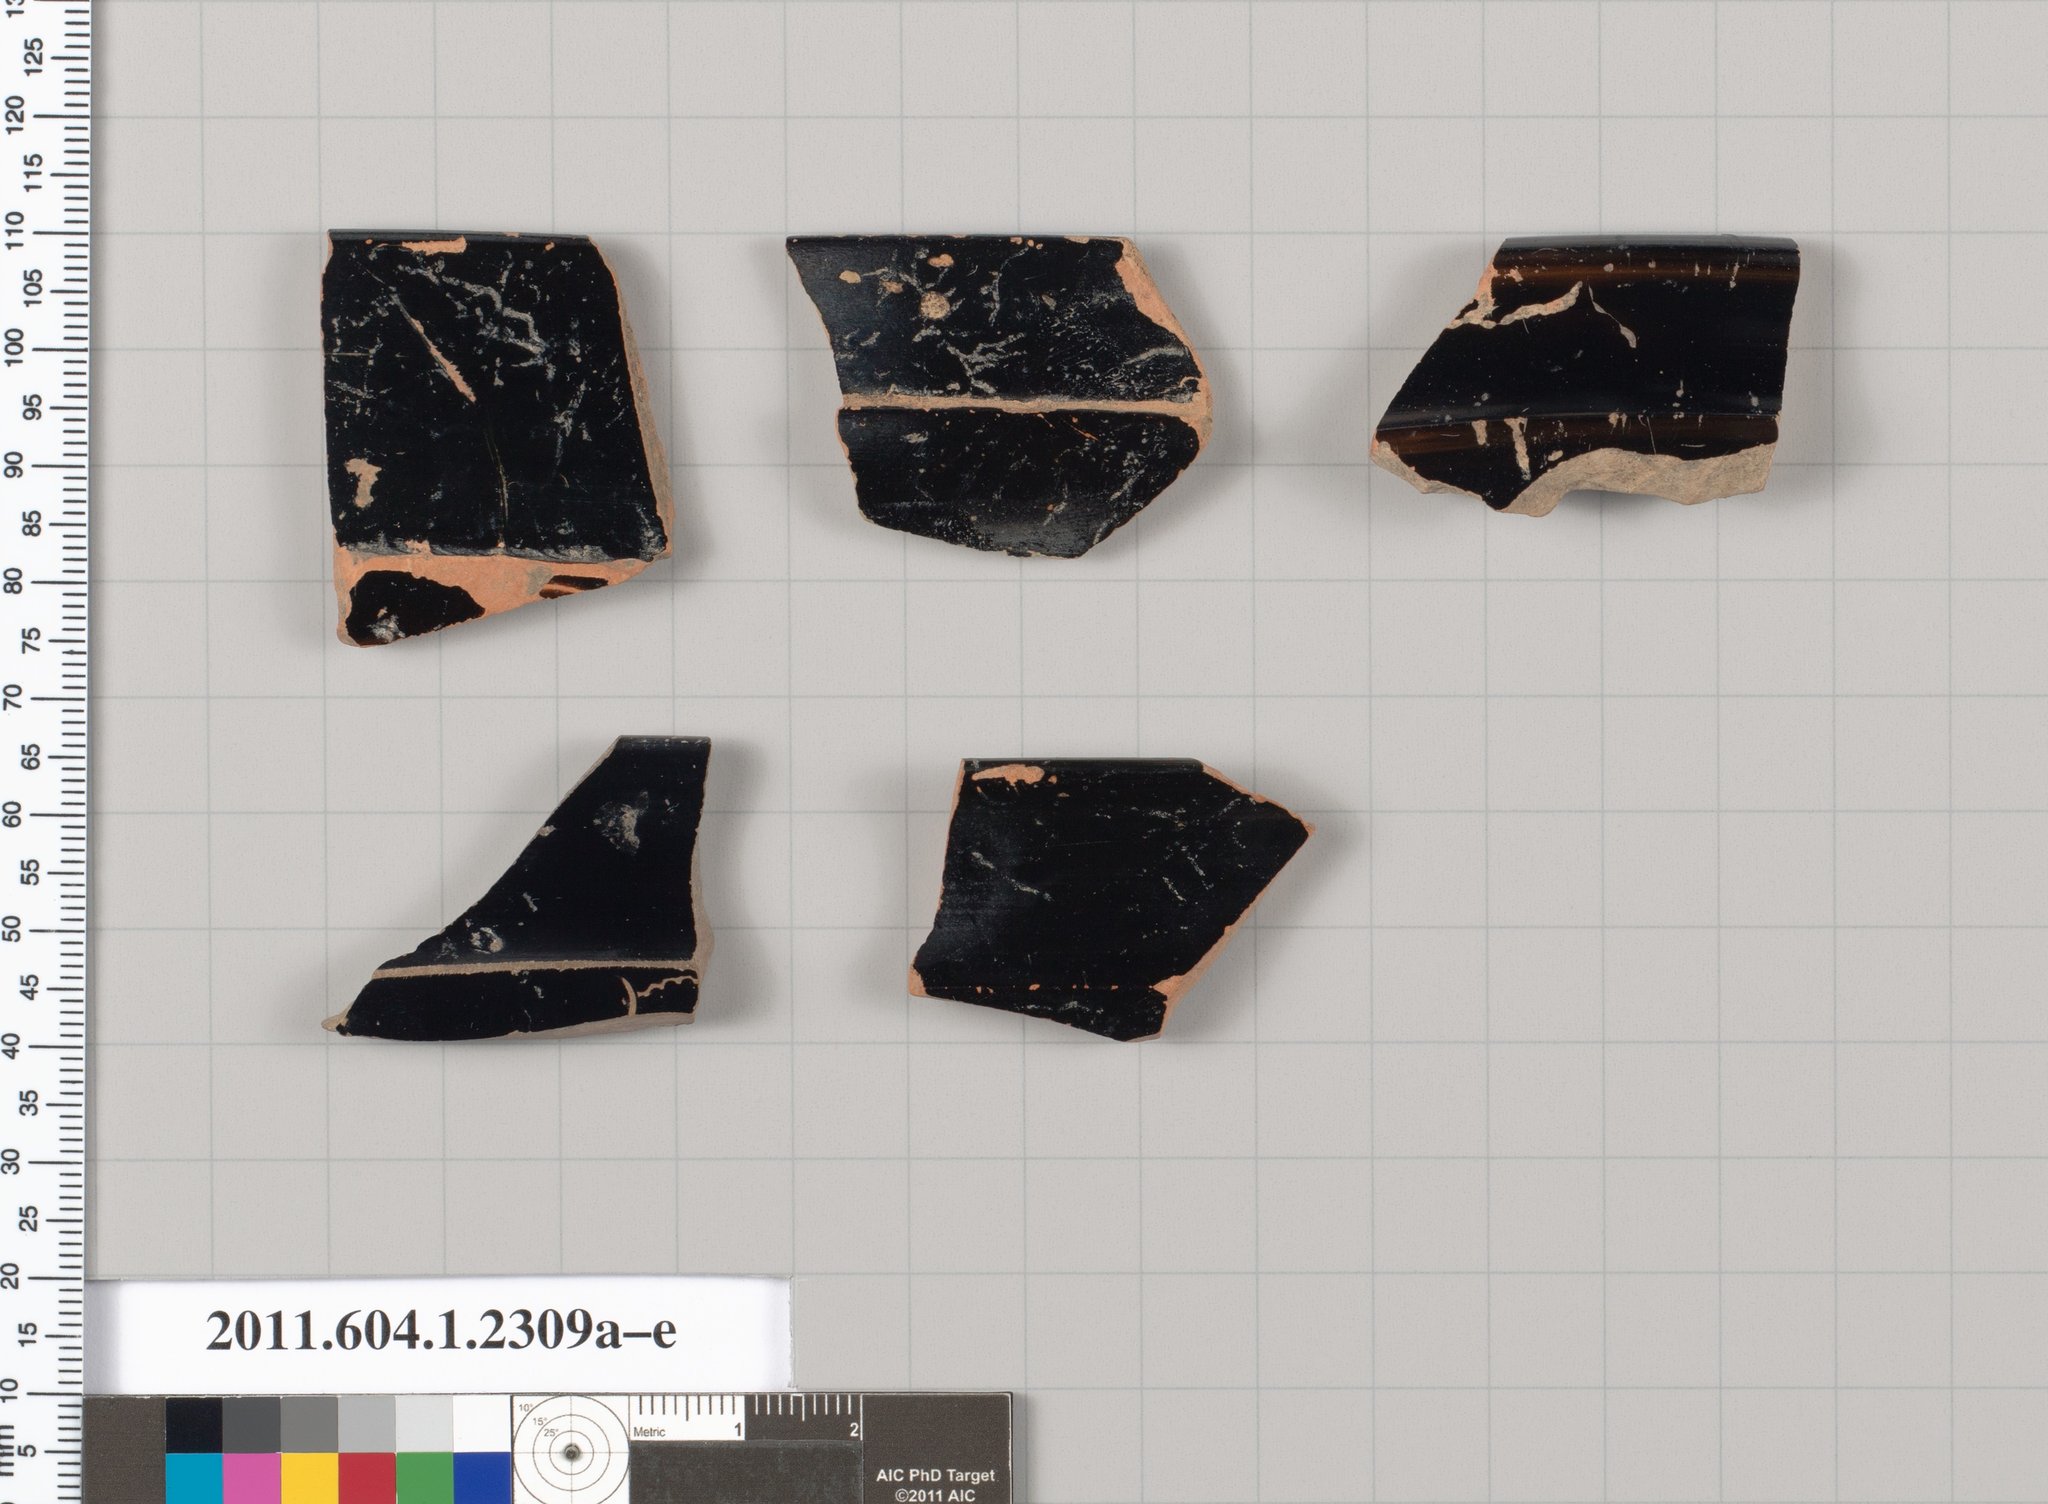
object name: kylix fragment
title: Terracotta rim fragments of kylikes (drinking cups)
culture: greek, attic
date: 500-451 BCE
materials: terracotta